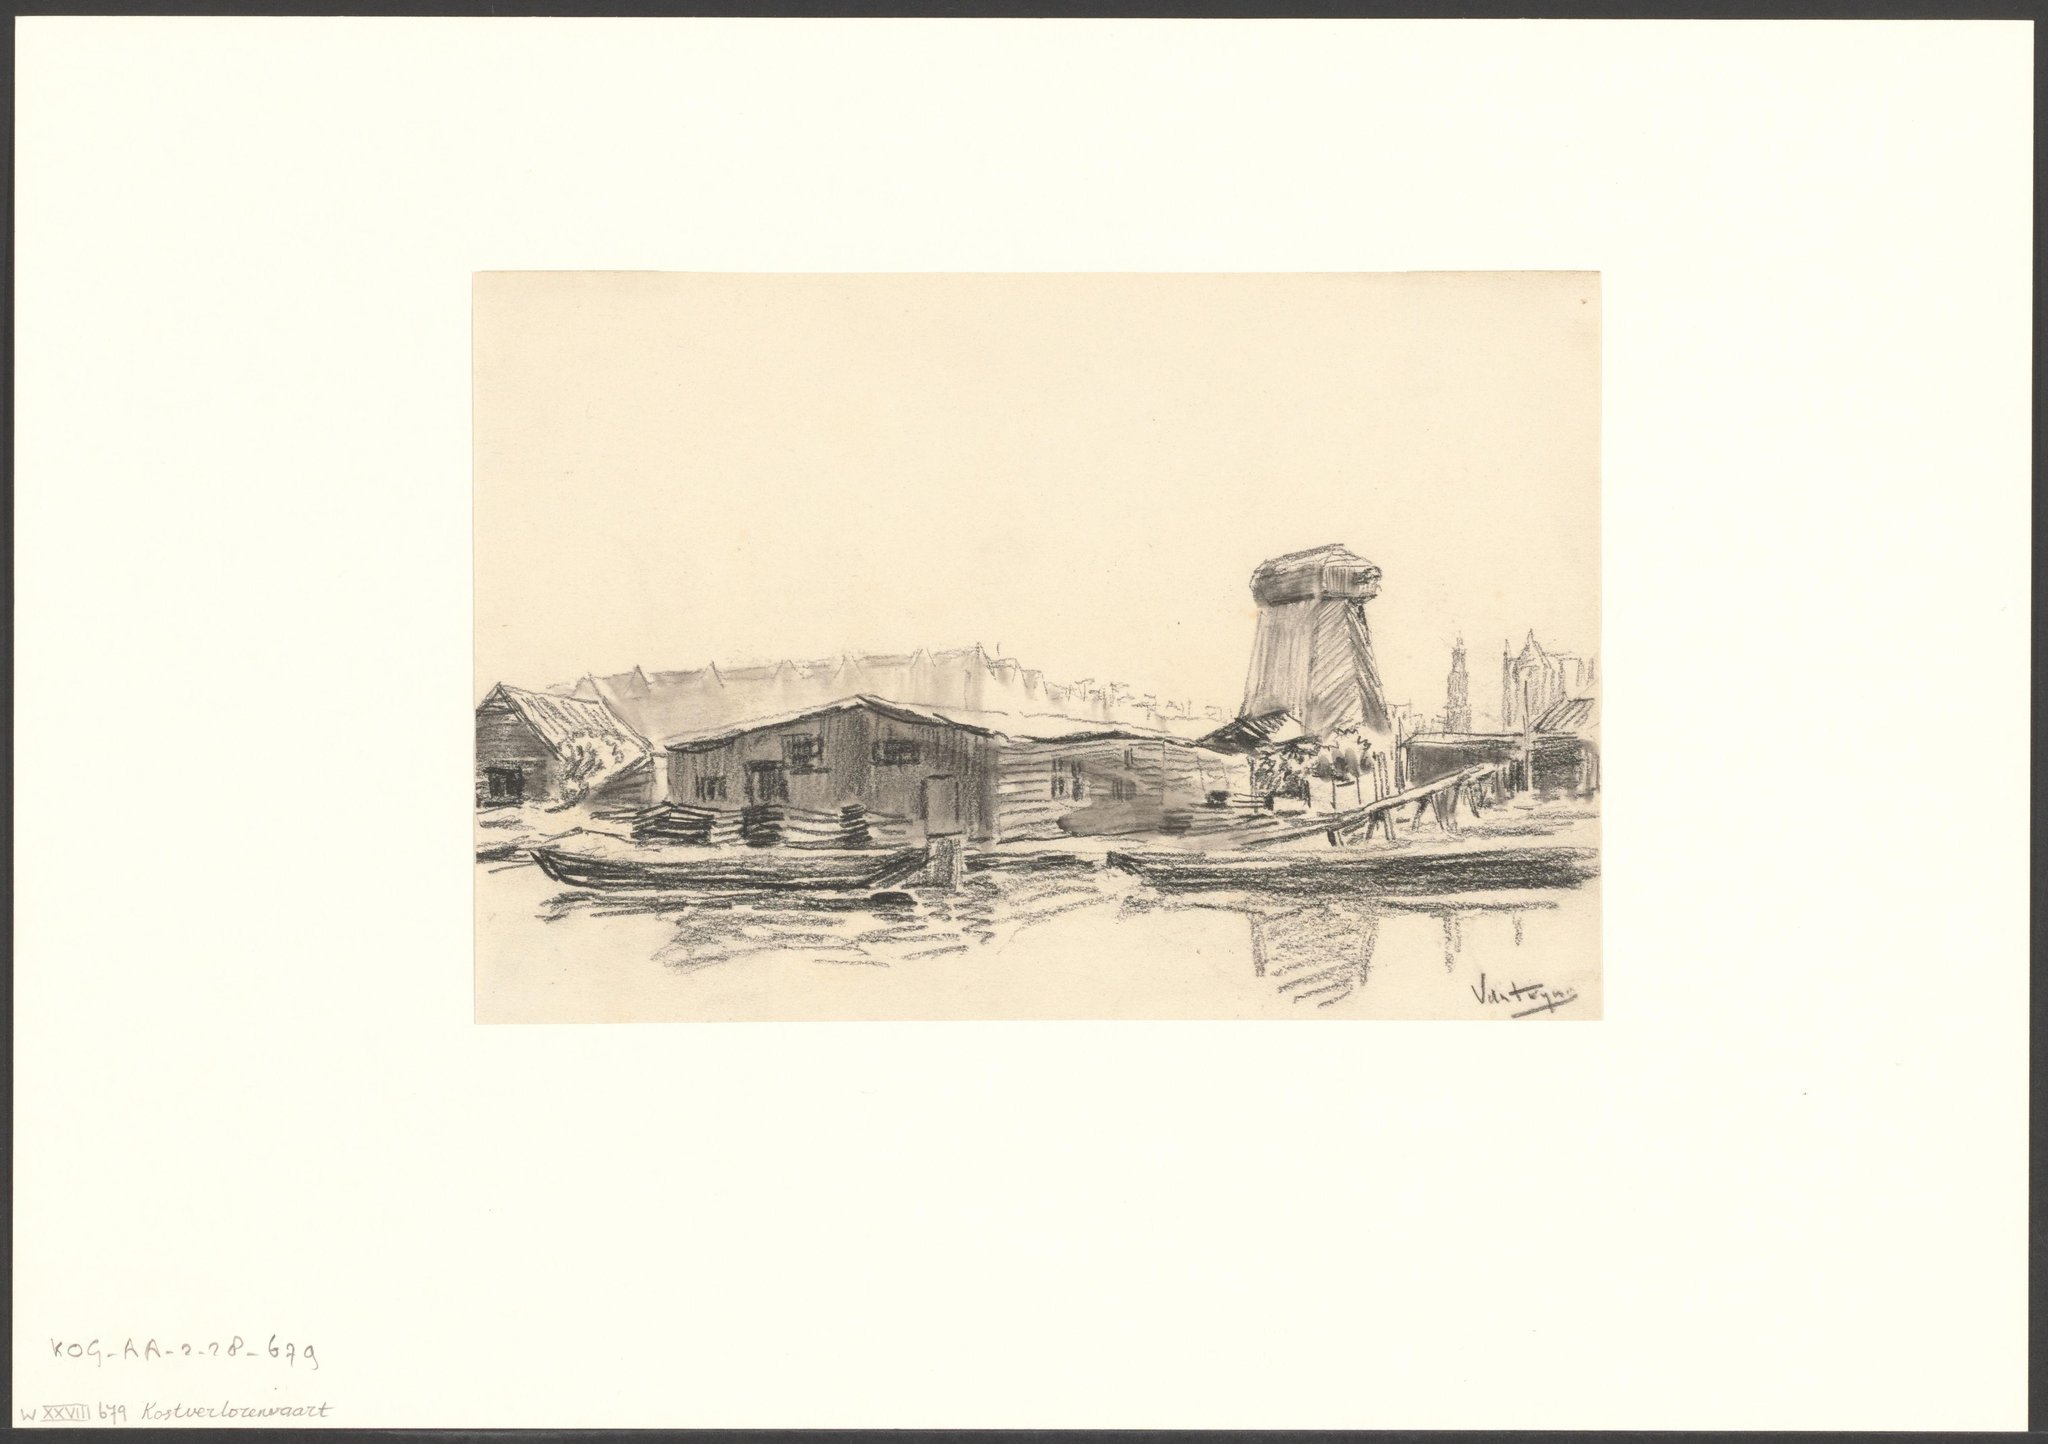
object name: drawing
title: Gezicht vanaf de Buyskade over de Kostverlorenvaart naar molen De Otter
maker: anthonie van teijn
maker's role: draughtsman, painter, print maker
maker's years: 1863-1943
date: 1907-1927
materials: chalk, paper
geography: amsterdam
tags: city-view in general; 'veduta', canal, windmill in landscape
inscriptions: signature: ‘VanTeyne’, inscription: ‘Gezicht vanaf de (...) Juli 1927. / VanEck’, collector's mark: Lugt 800a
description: Tekening binnen de Atlas Van Eck ingedeeld op wijknummer 28.